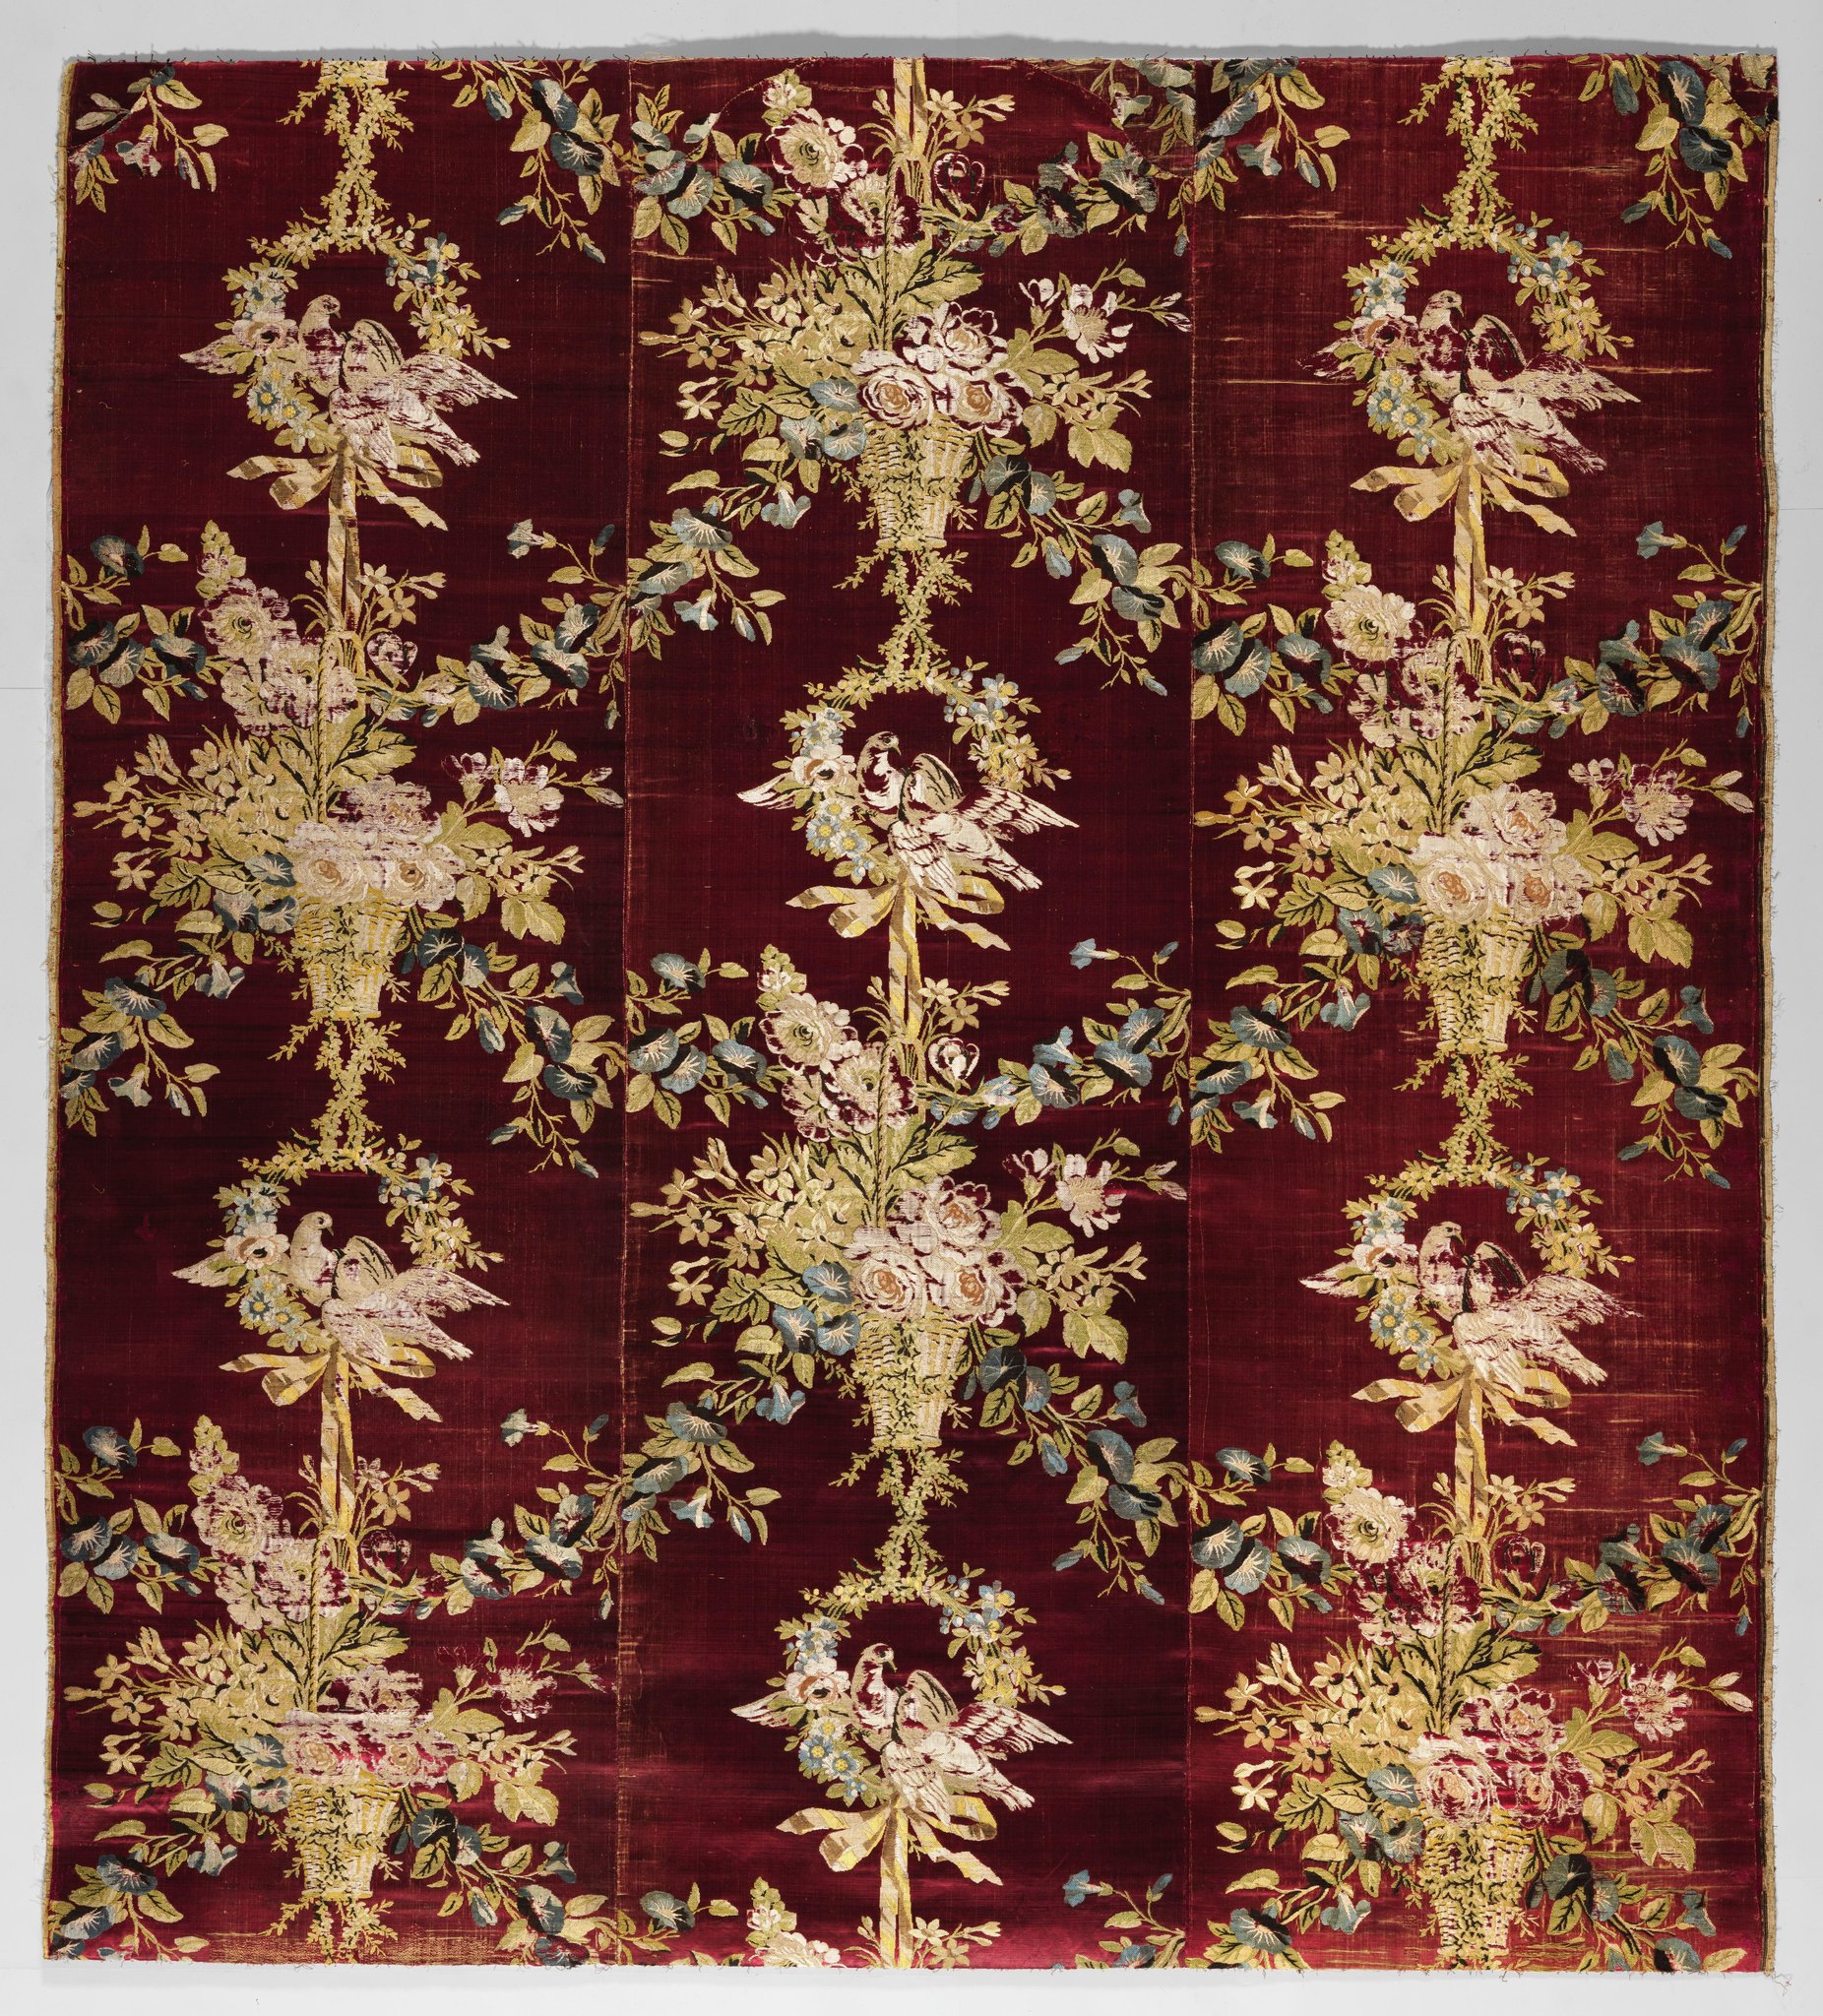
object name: upholstered wall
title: Wandbespanning van lampas met tortelduivenpatroon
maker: philippe de lasalle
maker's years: 1723-1805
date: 1770-1790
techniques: lampas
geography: lyon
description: Wandbespanning van lampas, waarop het tortelduiven-patroon tegen een cerise-rode fond. Textuur: fond in kettingsatijn: gebrocheerde inslag in linkse keperbinding; inslagdraden van getwijnde en van floszijde. Patroon: over de volle breedte zijn twee motieven onder elkaar gehangen: een hoge rand is assymetrisch gevuld met rozen, kelkbloemen (malva?), oranjebloesem (?) en stokroos. Een fijn bladrankje windt zich om de mand en houdt in een lus een bloemkransje, waarin twee tortelduiven en waaronder een geel lint is gestrikt, waaraan het hengsel van de mand. Vier dubbele ranken van blauwe winde ontspringen aan de mand en vormen compartimenten met de duiven als midden. Kleuren: het overheersende crême-wit van het decor wordt verlevendigd door zachtgeel, rose, blauw, mosgroen en spaarzaam donkerblauw of zwart. Deze wandbespanning was gemonteerd als tien paneelvullingen met geschulpte bovenkant, van twee patronen hoog en van één stofbreedte, vermeerderd met smalle ter weerszijden aangezette banen. De bespanning is uitgevoerd voor Keizerin Catharina II van Rusland.